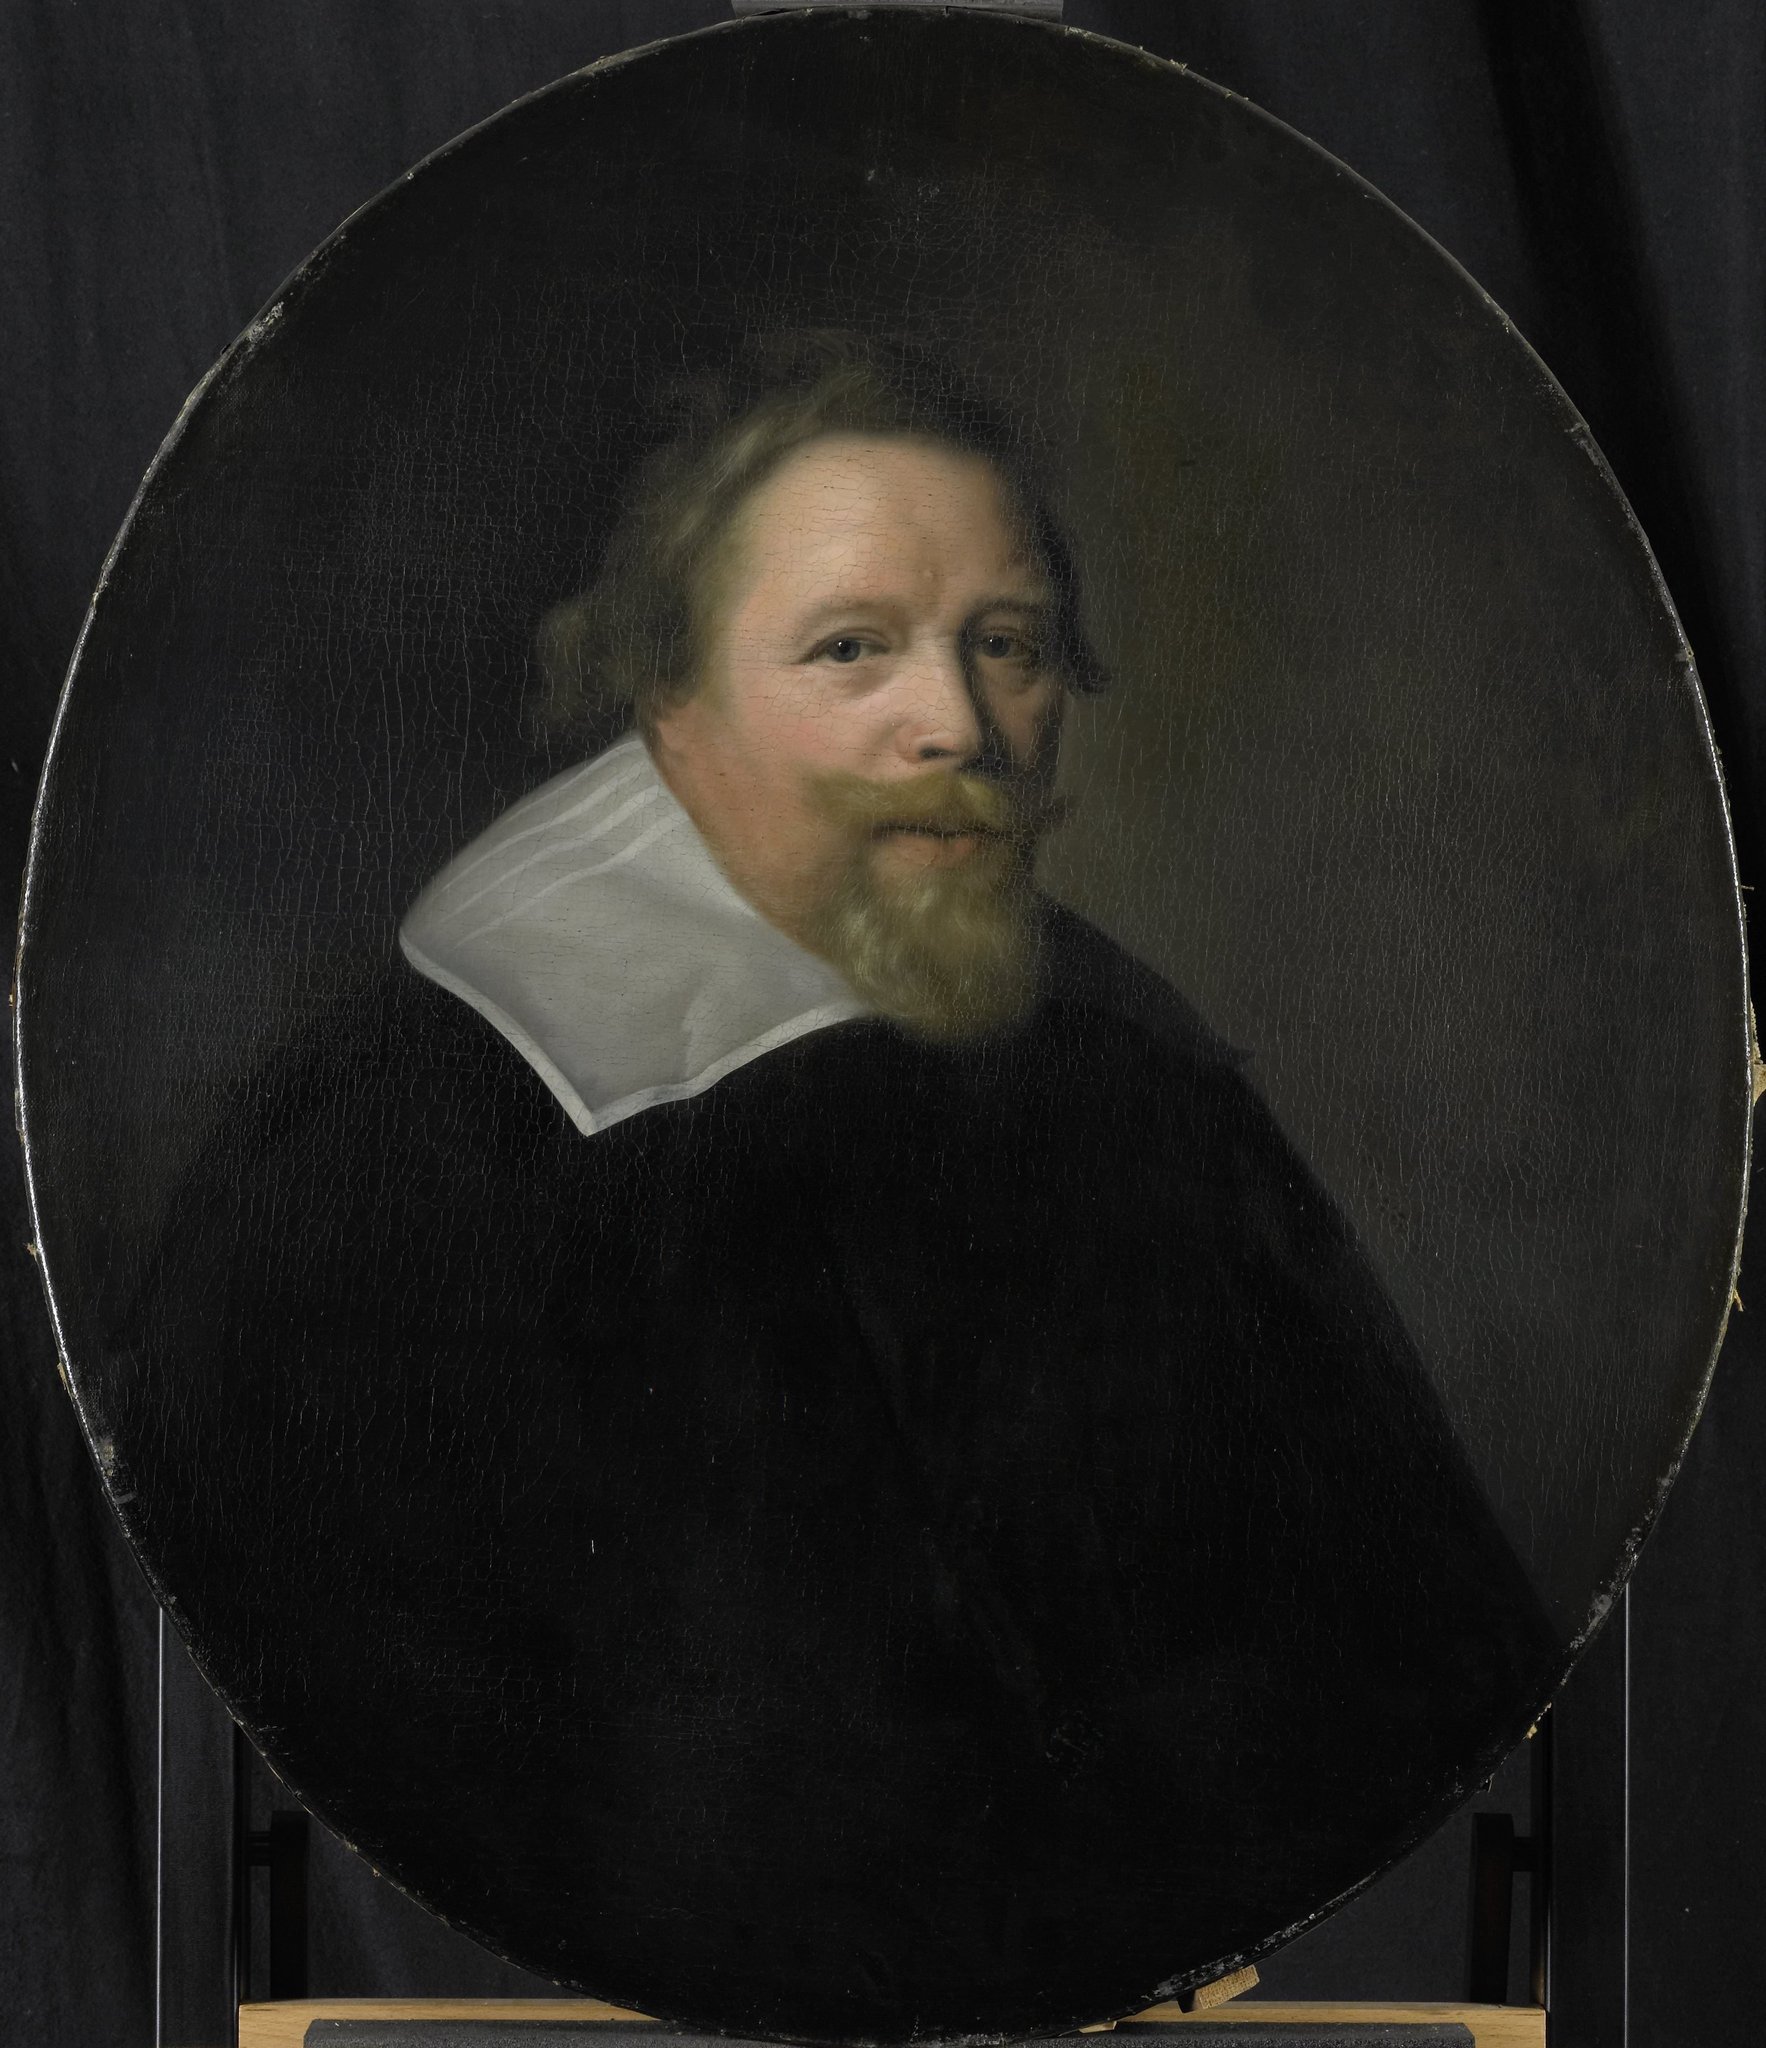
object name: painting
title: Portrait of Pieter Sonmans, Director of the Rotterdam Chamber of the Dutch East India Company, elected 1631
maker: pieter van der werff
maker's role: draughtsman, painter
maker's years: 1665-1722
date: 1695-1722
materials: canvas, oil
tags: rotterdam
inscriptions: inscription: ‘16 Peter Sonmans. 31’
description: Portret van Pieter Sonmans (1588-1660), gekozen in 1631. Buste in ovaal naar rechts. Onderdeel van een reeks portretten van de bewindhebbers van de Rotterdamse Kamer van de Verenigde Oost-Indische Compagnie, vervaardigd voor het Nieuw Oost-Indisch Huis uit 1698 aan de Boompjes te Rotterdam.